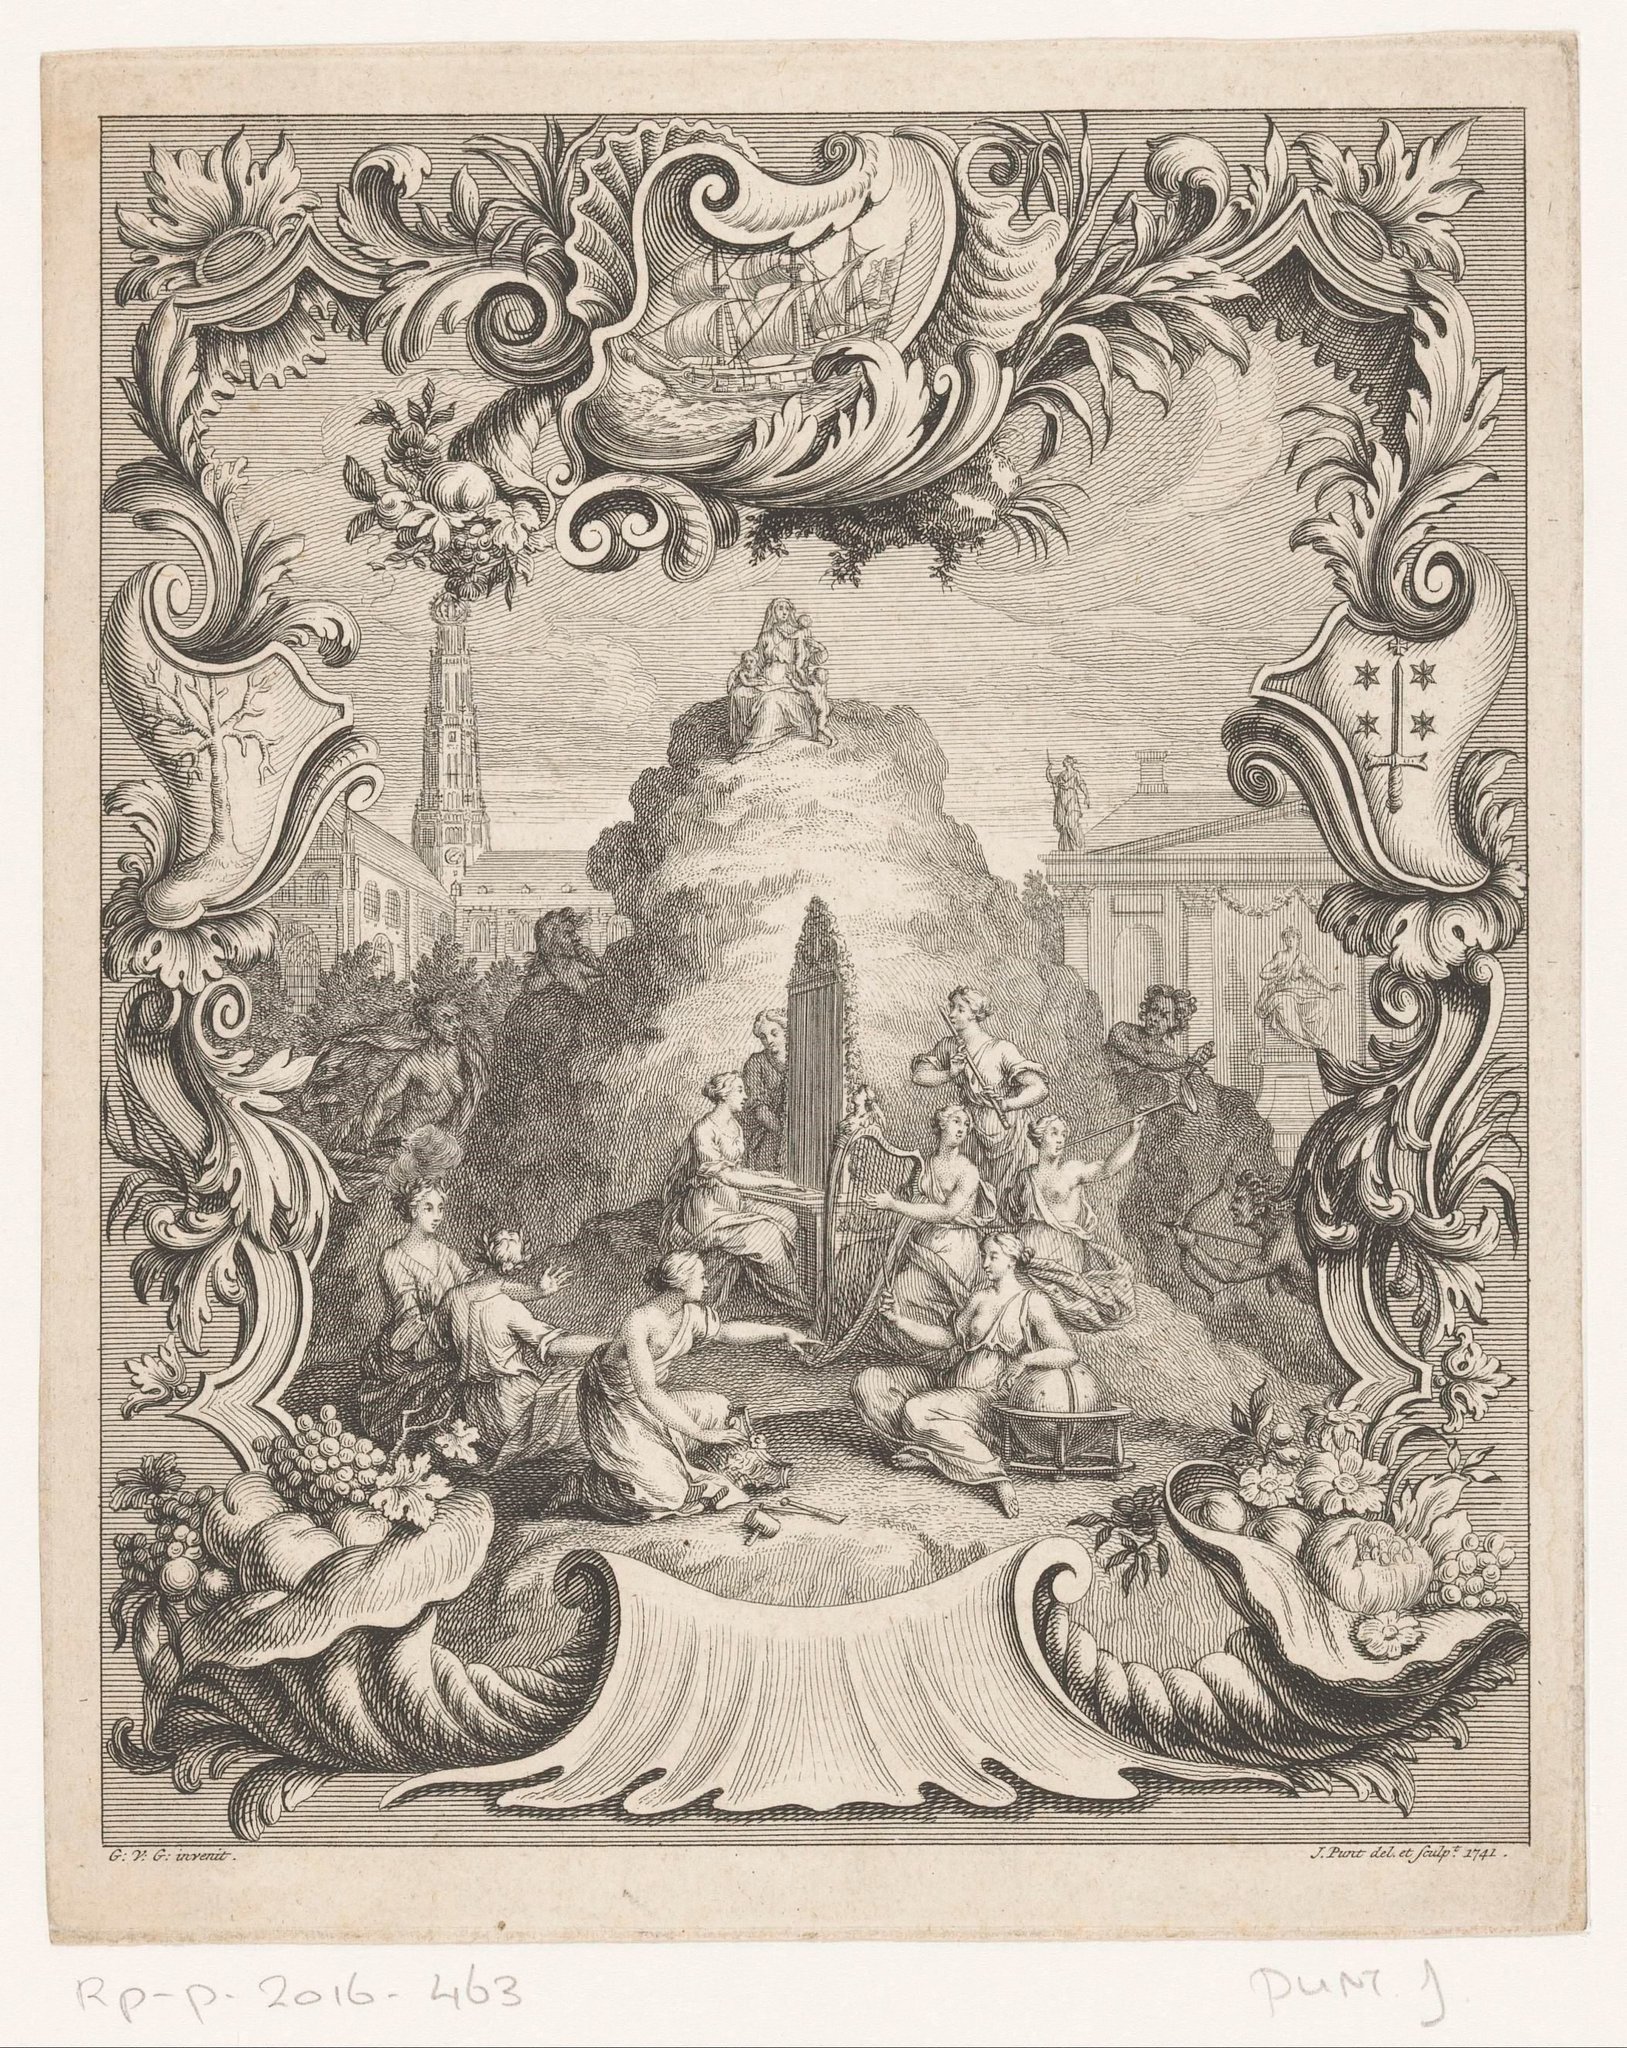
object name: print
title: Allegorische voorstelling met personificaties van de kunsten en wetenschappen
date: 1741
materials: paper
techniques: engraving, etching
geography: amsterdam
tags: charity, 'caritas'; 'carità' (ripa) ~ one of the three theological virtues, symbolic representations, allegories and emblems ~ science, 'scientia'; 'scienza', 'studio' (ripa), devil or demons attacking mortals, symbolic representations, allegories and emblems ~ art; 'arte' (ripa)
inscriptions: date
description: Personificaties van de kunsten en wetenschappen hebben zich verzameld op een berg. Helemaal bovenaan zit Liefde (Caritas). Duivelse figuren rondom hen proberen hen te belagen. Op de achtergrond de Grote kerk te Haarlem. De voorstelling is gevat in een omlijsting gedecoreerd met bladwerk, wapenschilden en cartouches.